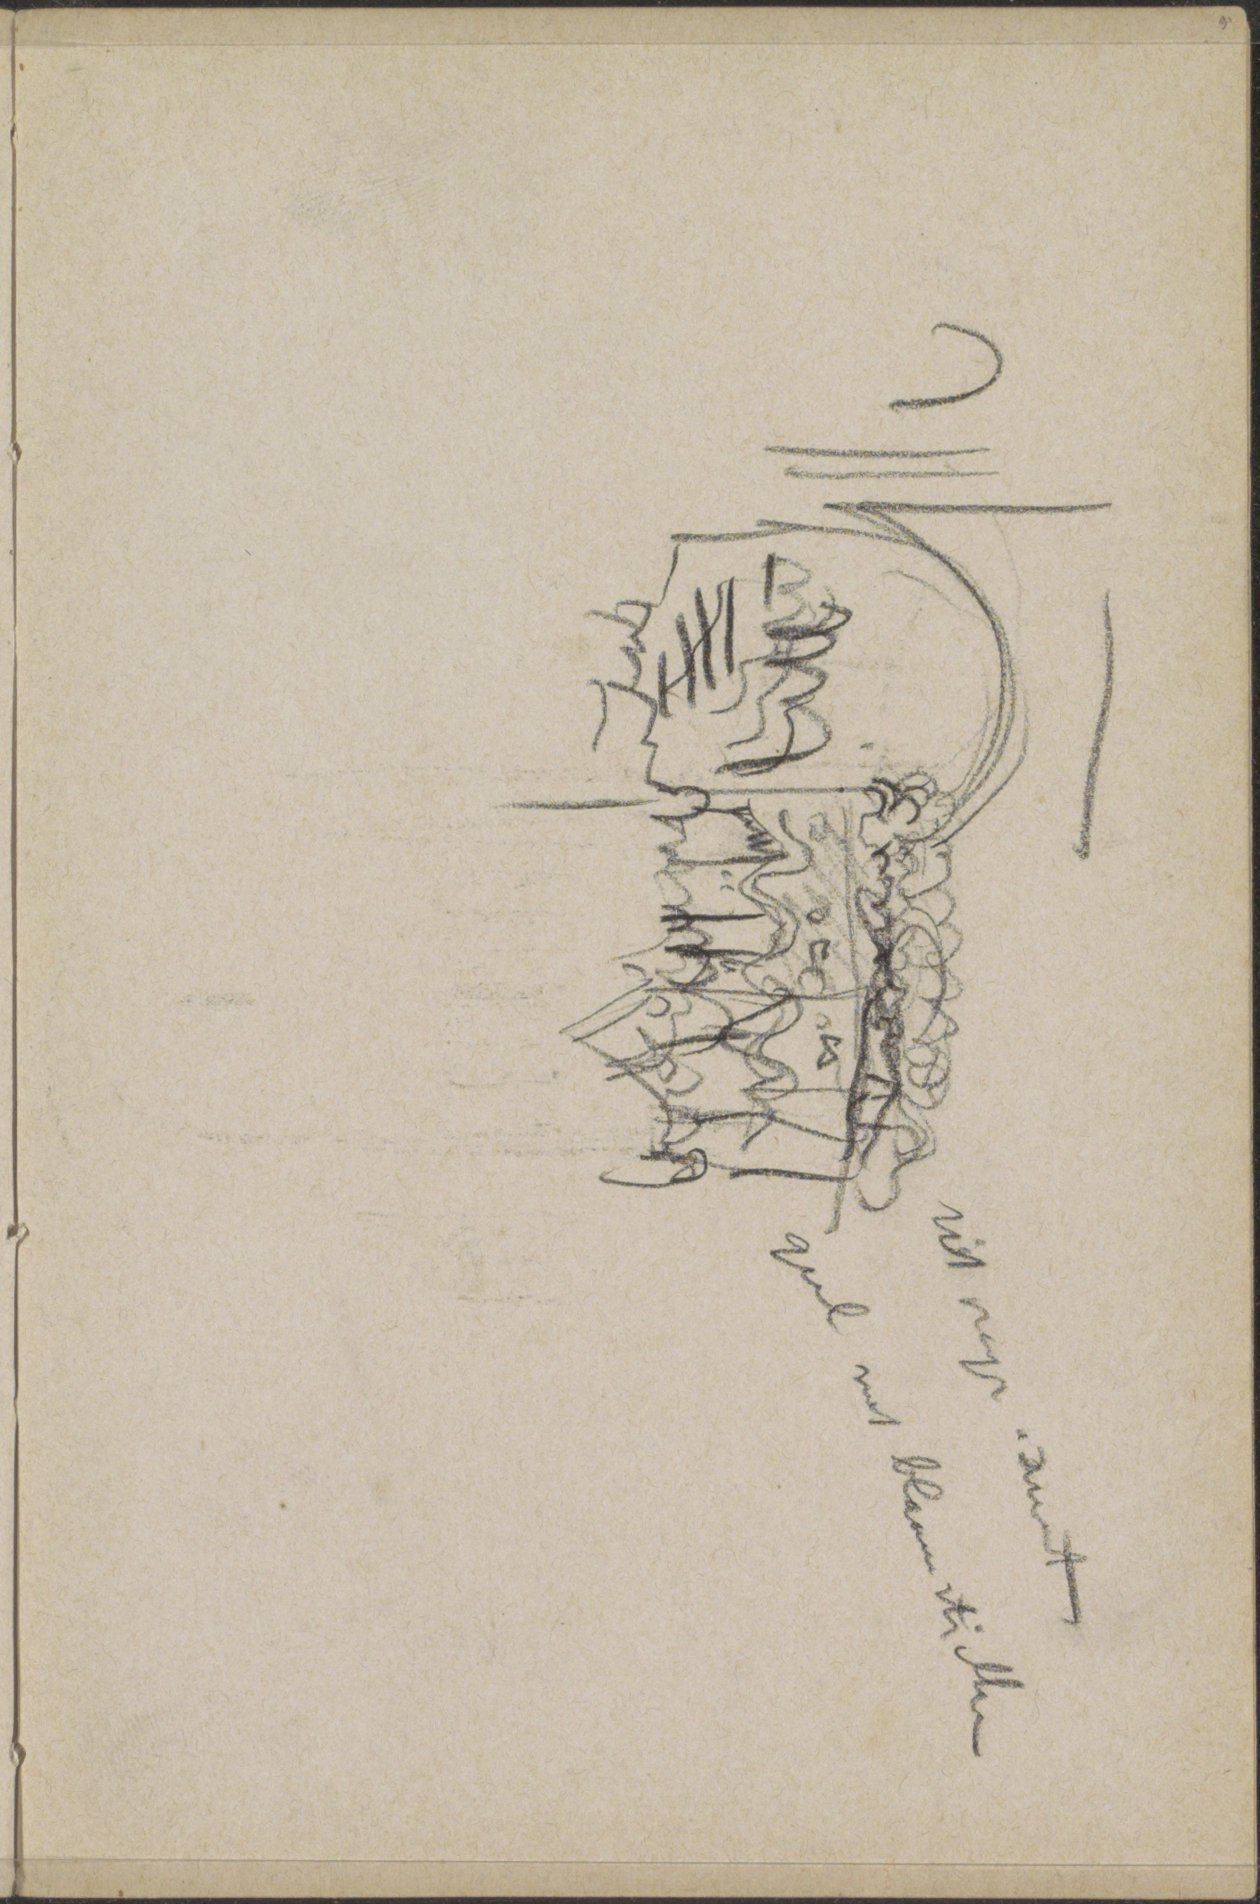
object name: sketchbook leaf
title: Figuren met eeen baldakijn bij de trap van het Granovitaya Palata te Moskou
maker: marius bauer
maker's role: draughtsman, print maker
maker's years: 1867-1932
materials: chalk, paper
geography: moscow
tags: flight of steps, canopy, baldachin, carrying something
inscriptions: kleurnotitie, handgeschreven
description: De trap en veranda van het paleis maakten deel uit van de route van de processie voor de kroning van tsaar Nicolaas II. Pagina 91 uit een schetsboek met 54 bladen.